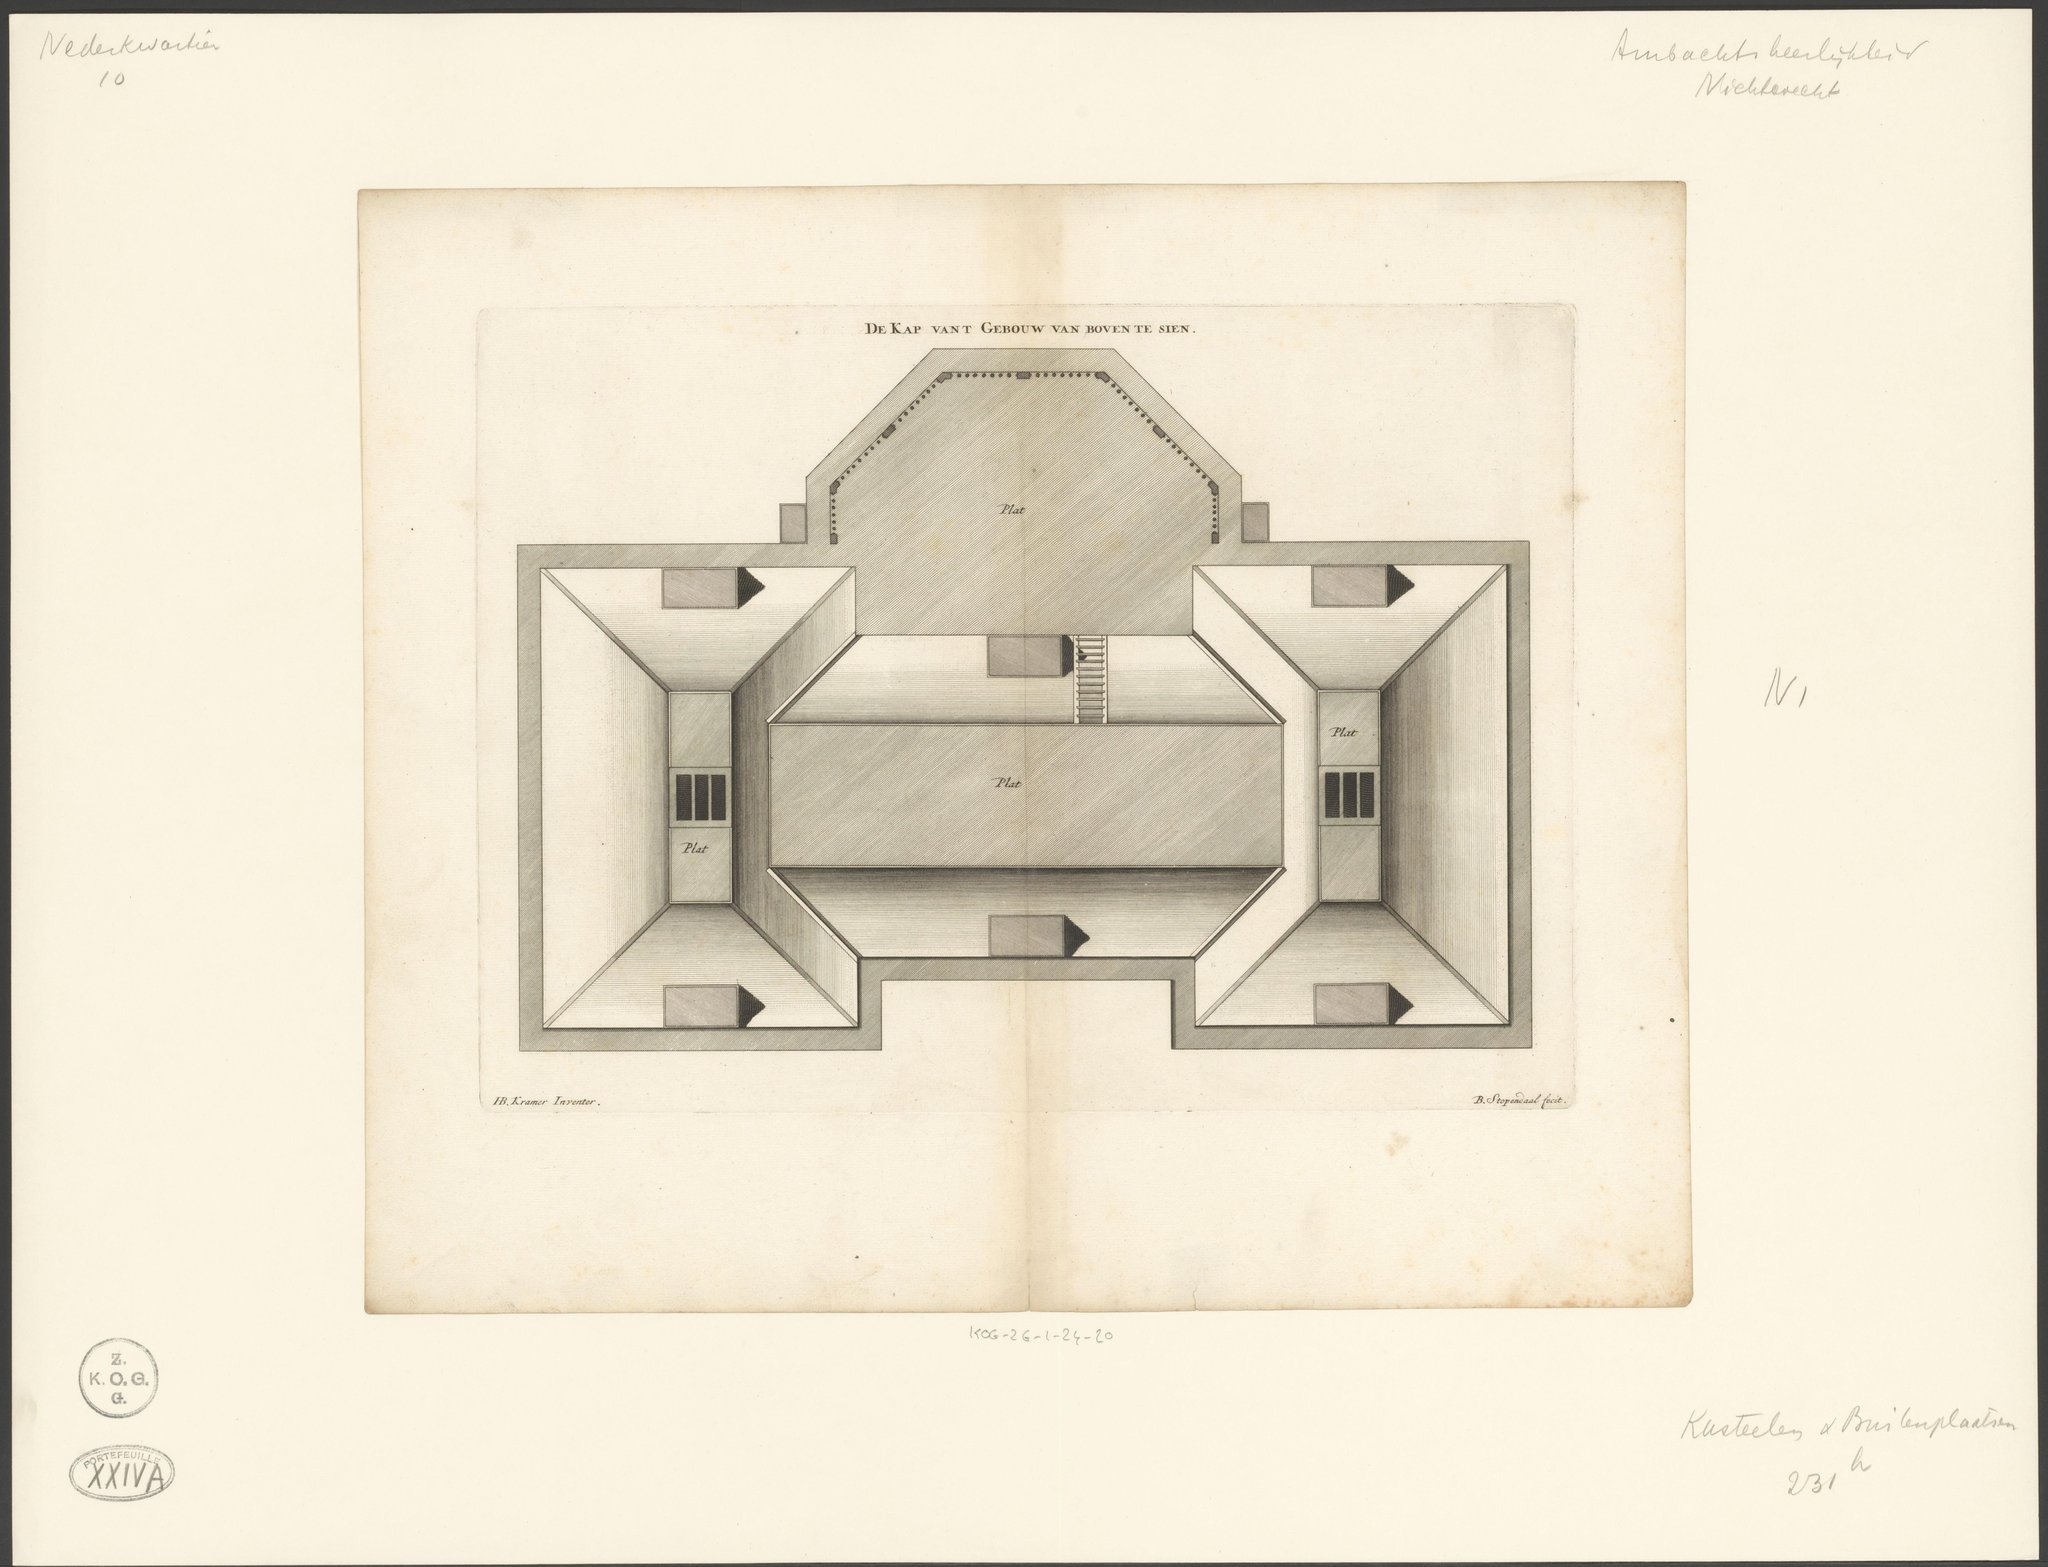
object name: print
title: De Kap van t Gebouw van boven te sien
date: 1687-1693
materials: paper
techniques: etching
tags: plan ~ architecture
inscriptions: stamp, collector's mark: Lugt 1641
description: Bovenaanzicht van het dak van huis De Nes te Vreeland. Het voor de Amsterdamse familie Reaal in 1687 gebouwde buitenhuis lag op een eiland in de Vecht. Onderwerpsrubrieken binnen de Atlas Zeden en Gewoonten: Zeden en Gewoonten in Engeren Zin, De Woning. Kastelen en buitenplaatsen. Utrecht (vervolg.).